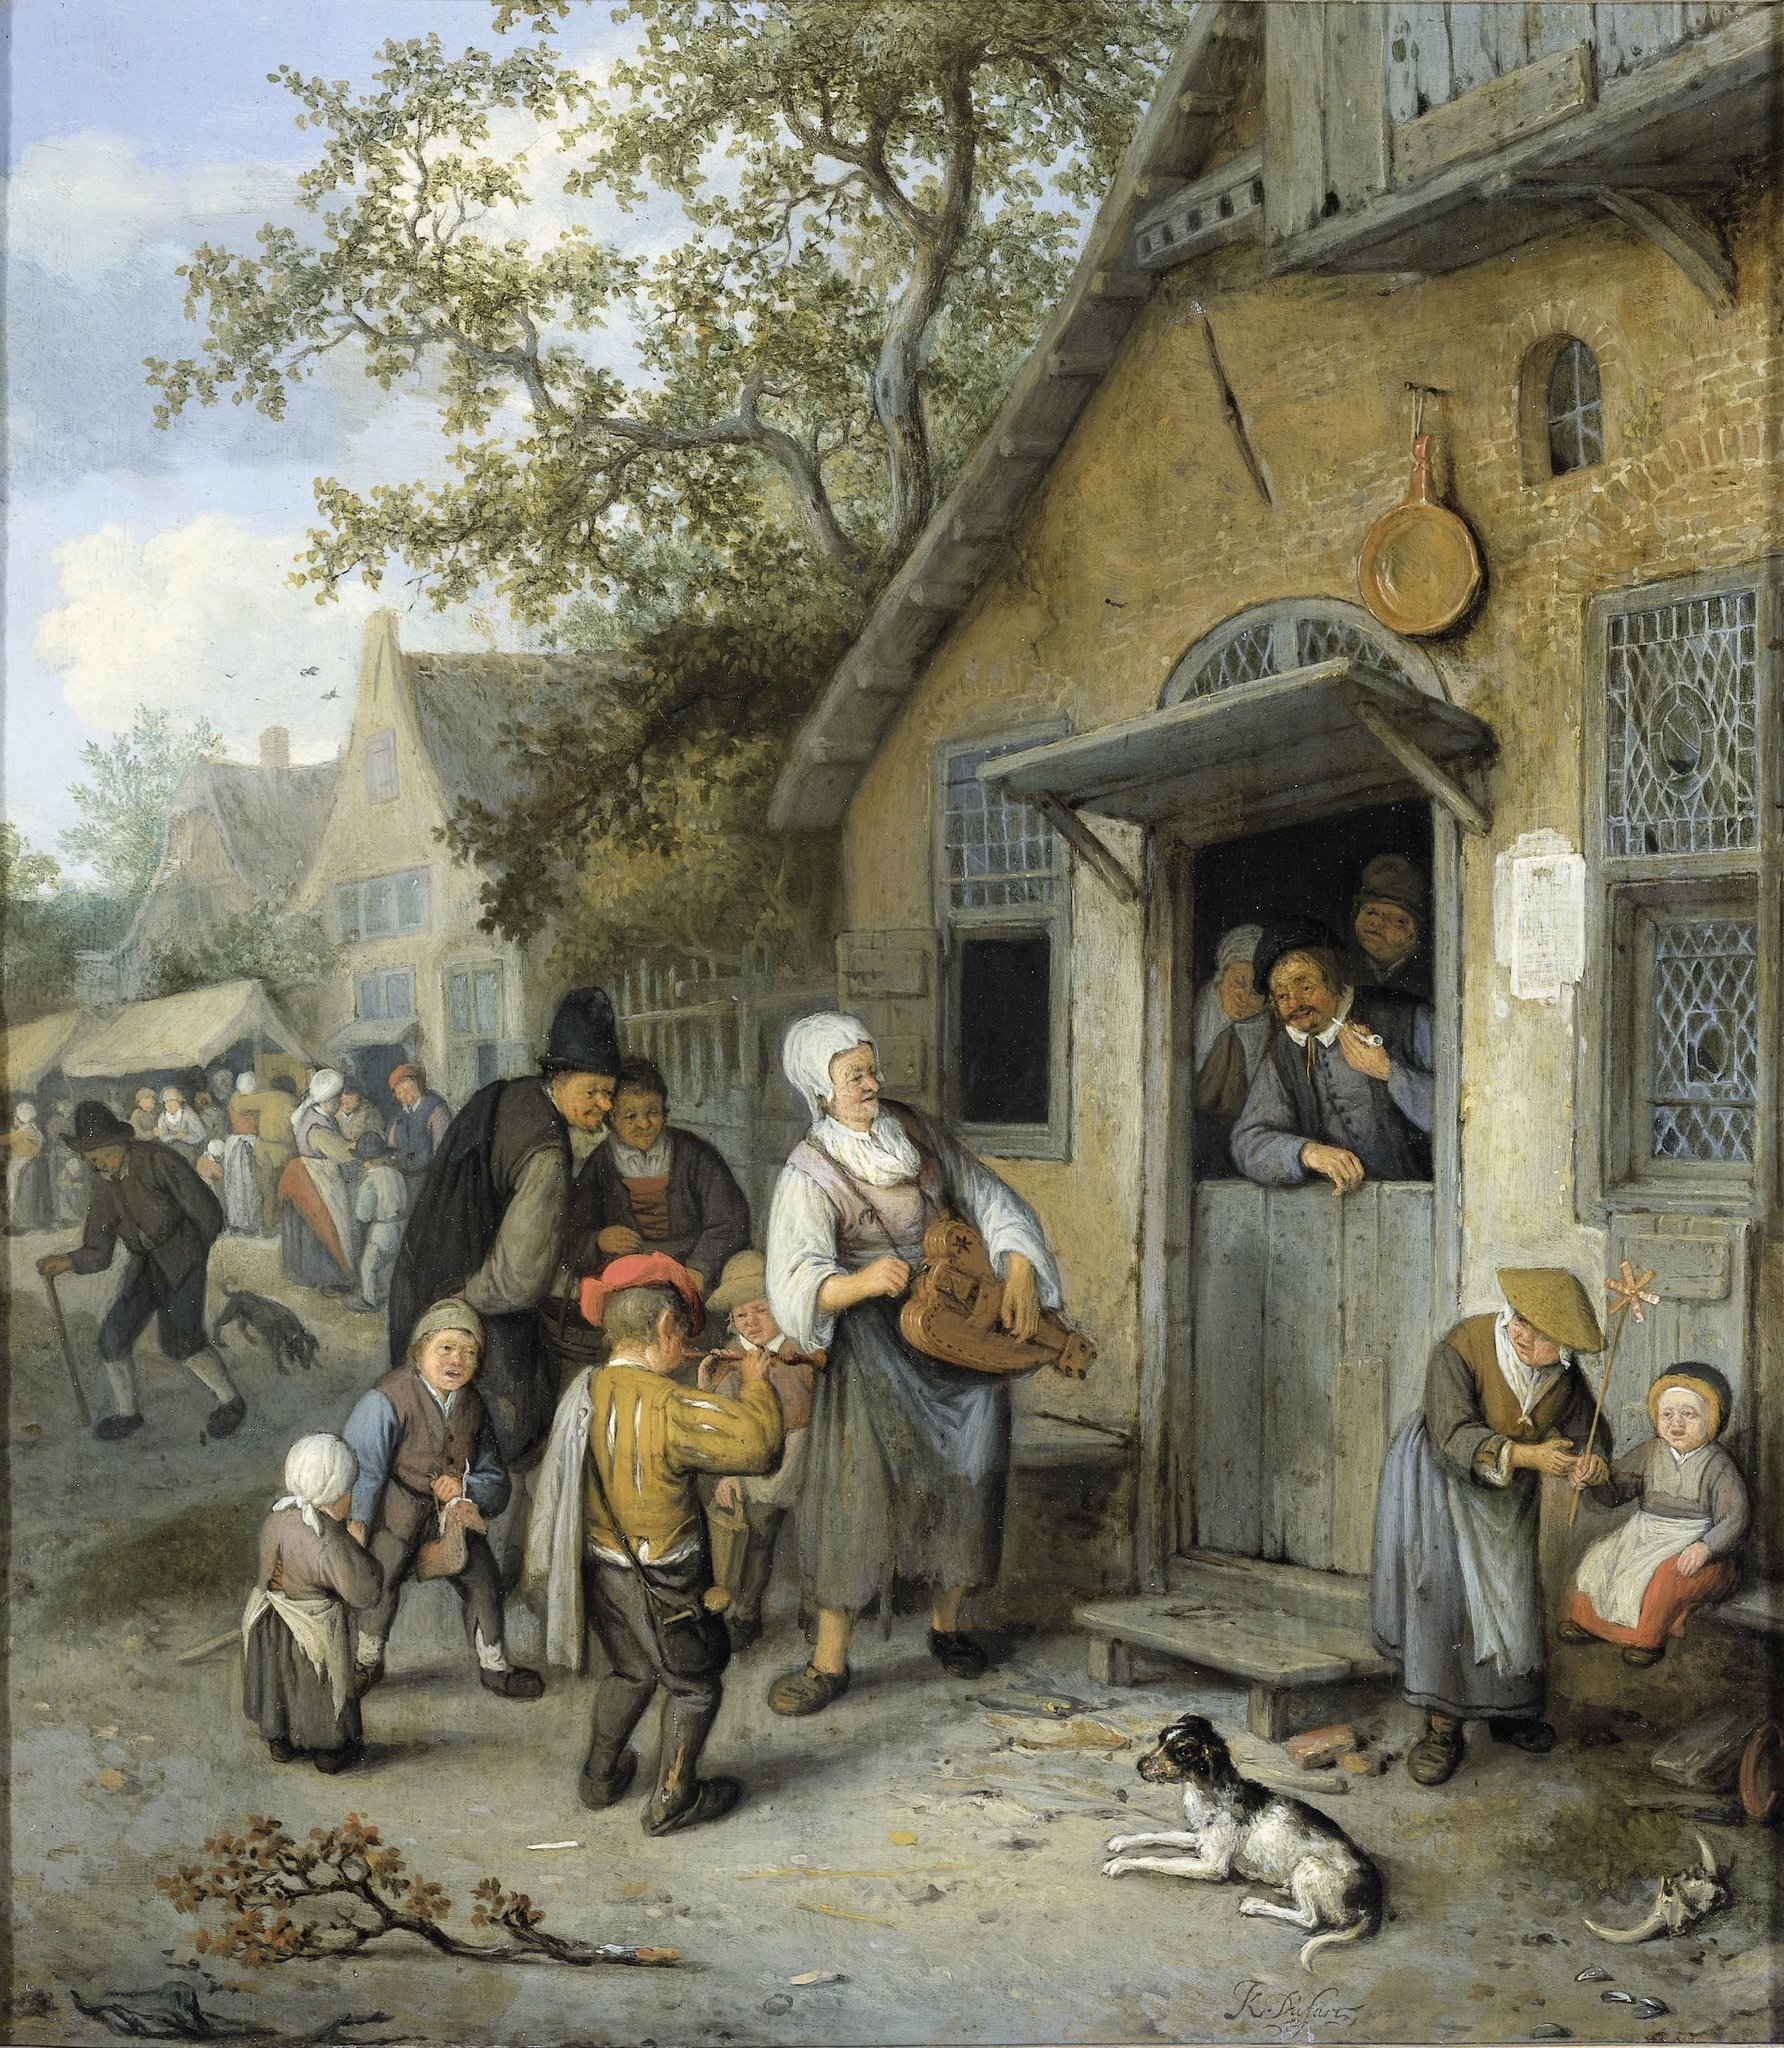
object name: painting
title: Country Kermis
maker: cornelis dusart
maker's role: draughtsman, painter, print maker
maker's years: 1660-1704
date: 1680-1704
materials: oil, panel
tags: hurdy-gurdy - cc - out of doors, village street, flute, aulos, tibia - cc - out of doors, festivities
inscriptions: signature: ‘K. Dusart.’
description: Boerenkermis. Voor de ingang van een huis speelt een vrouw op een draailier en een jongen op de fluit. Geleund over de onderdeur luistert een man met een pijp naar de muzikanten. Voor het huis spelende kinderen en een hond, in de verte de stalletjes van de kermis.